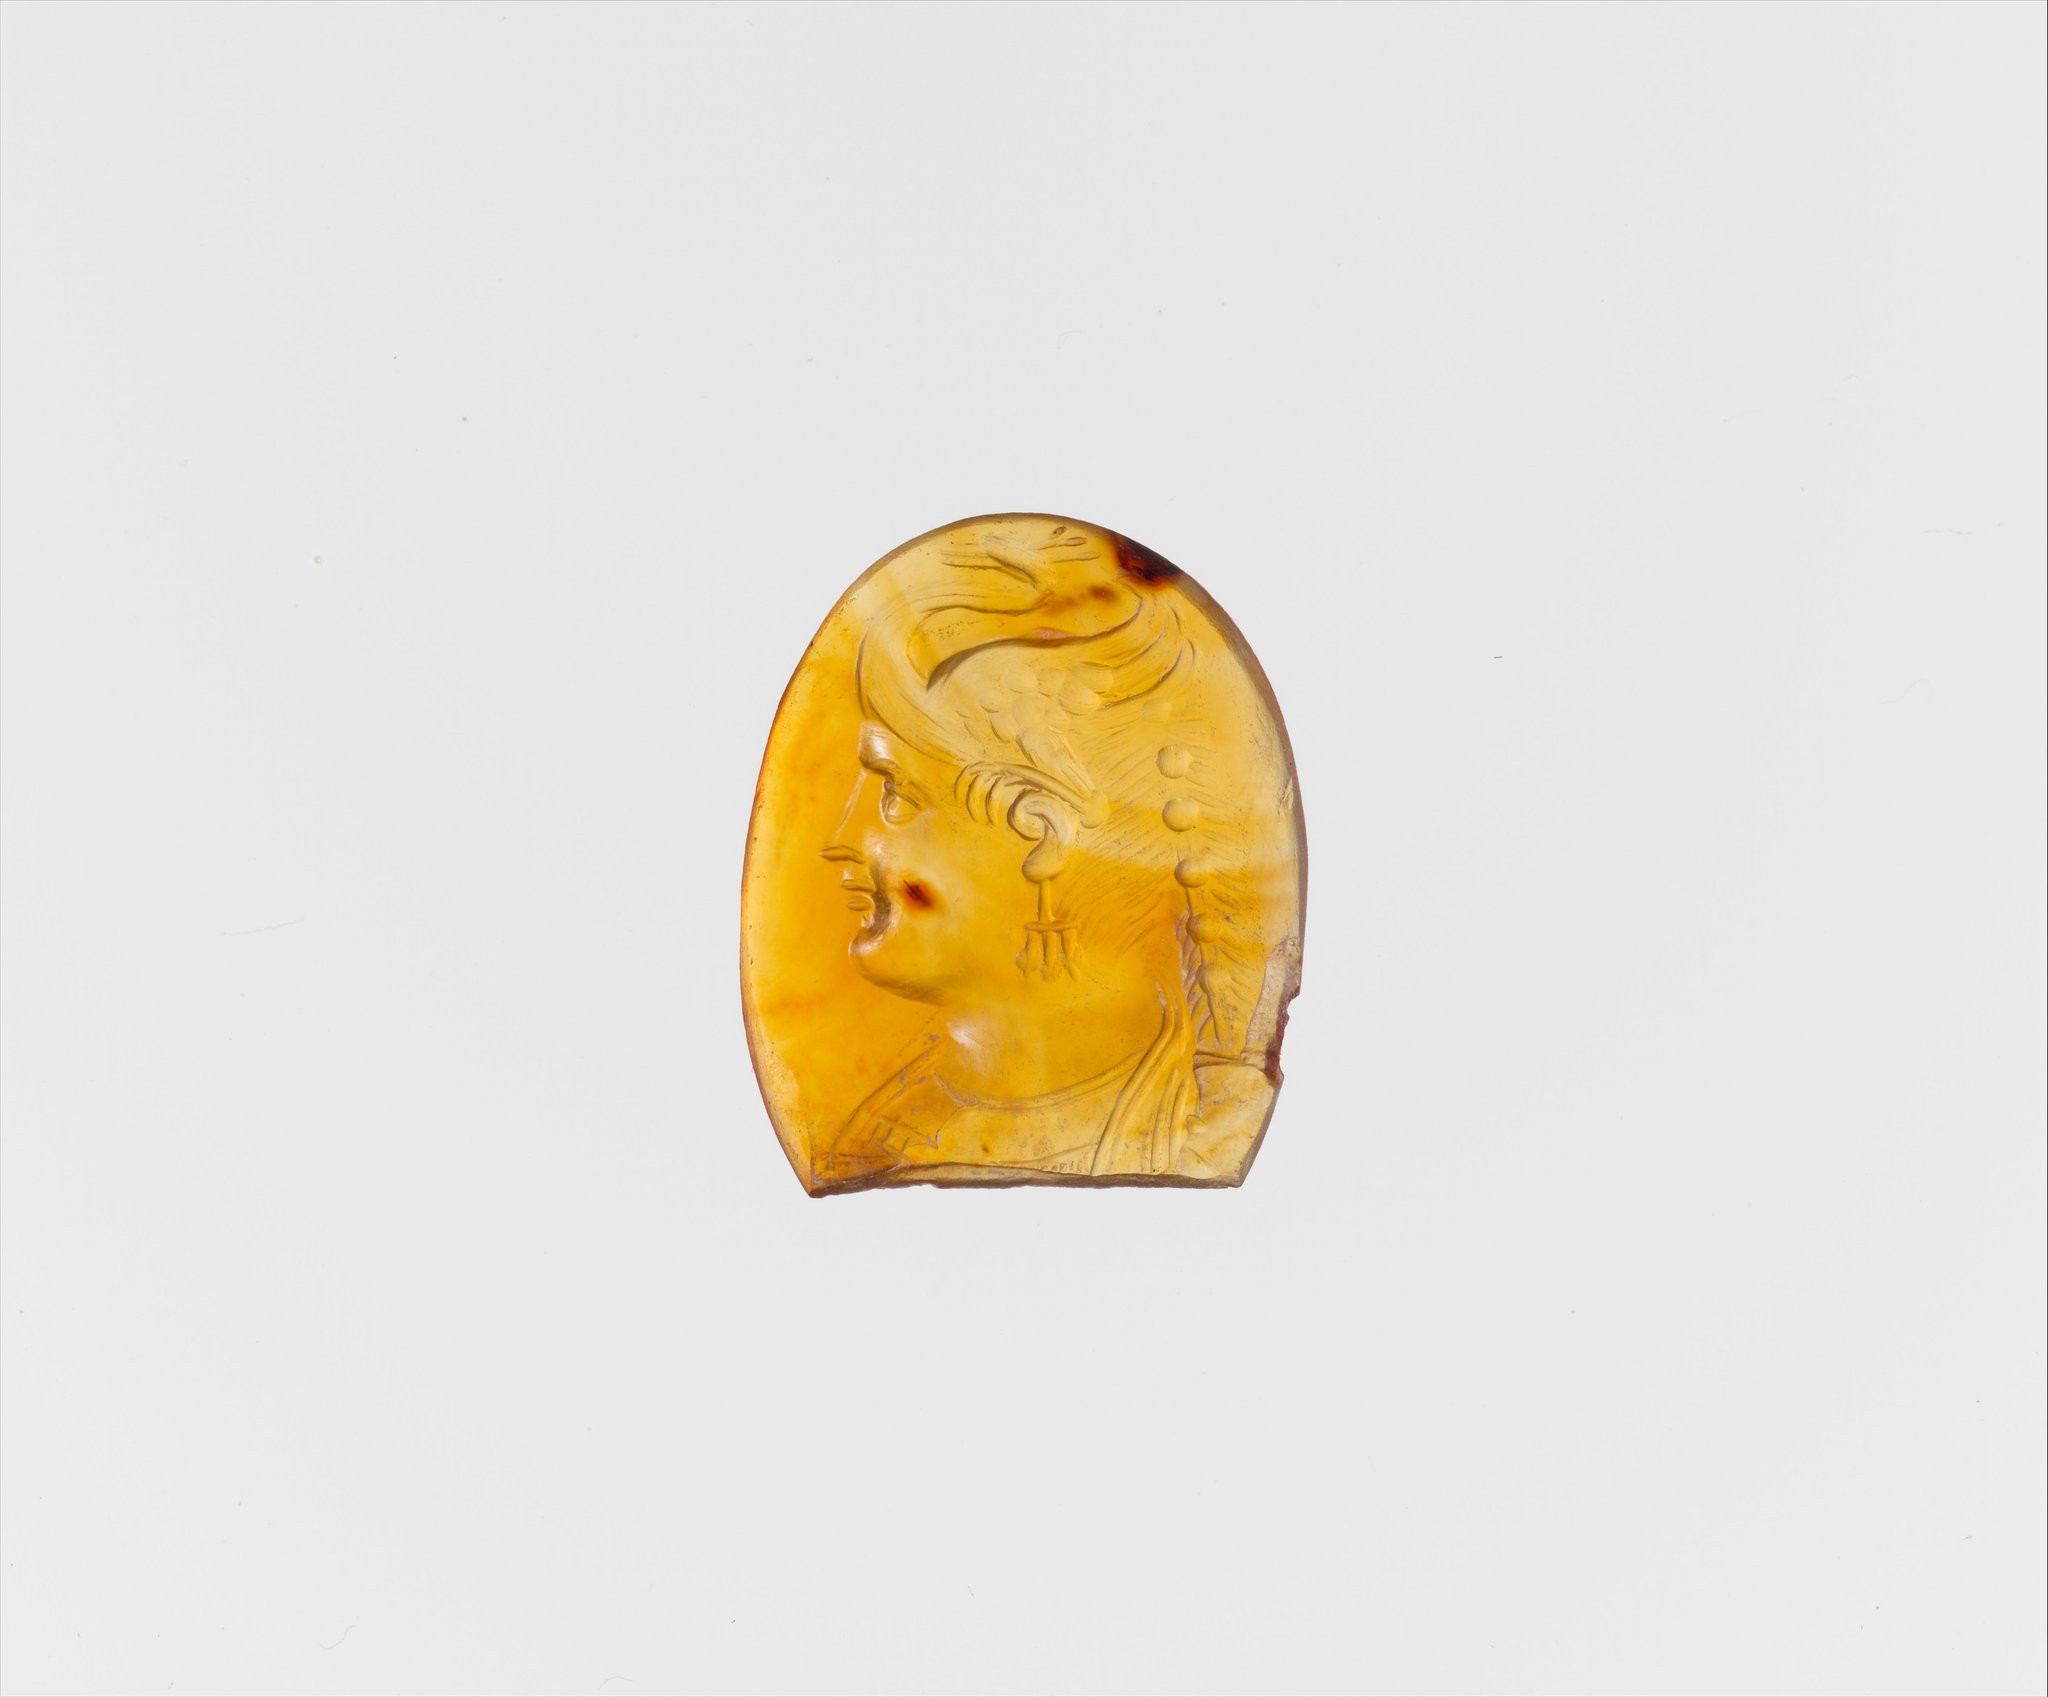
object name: intaglio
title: Sard ring stone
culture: roman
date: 100 BCE-300 CE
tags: profiles,women,peacocks